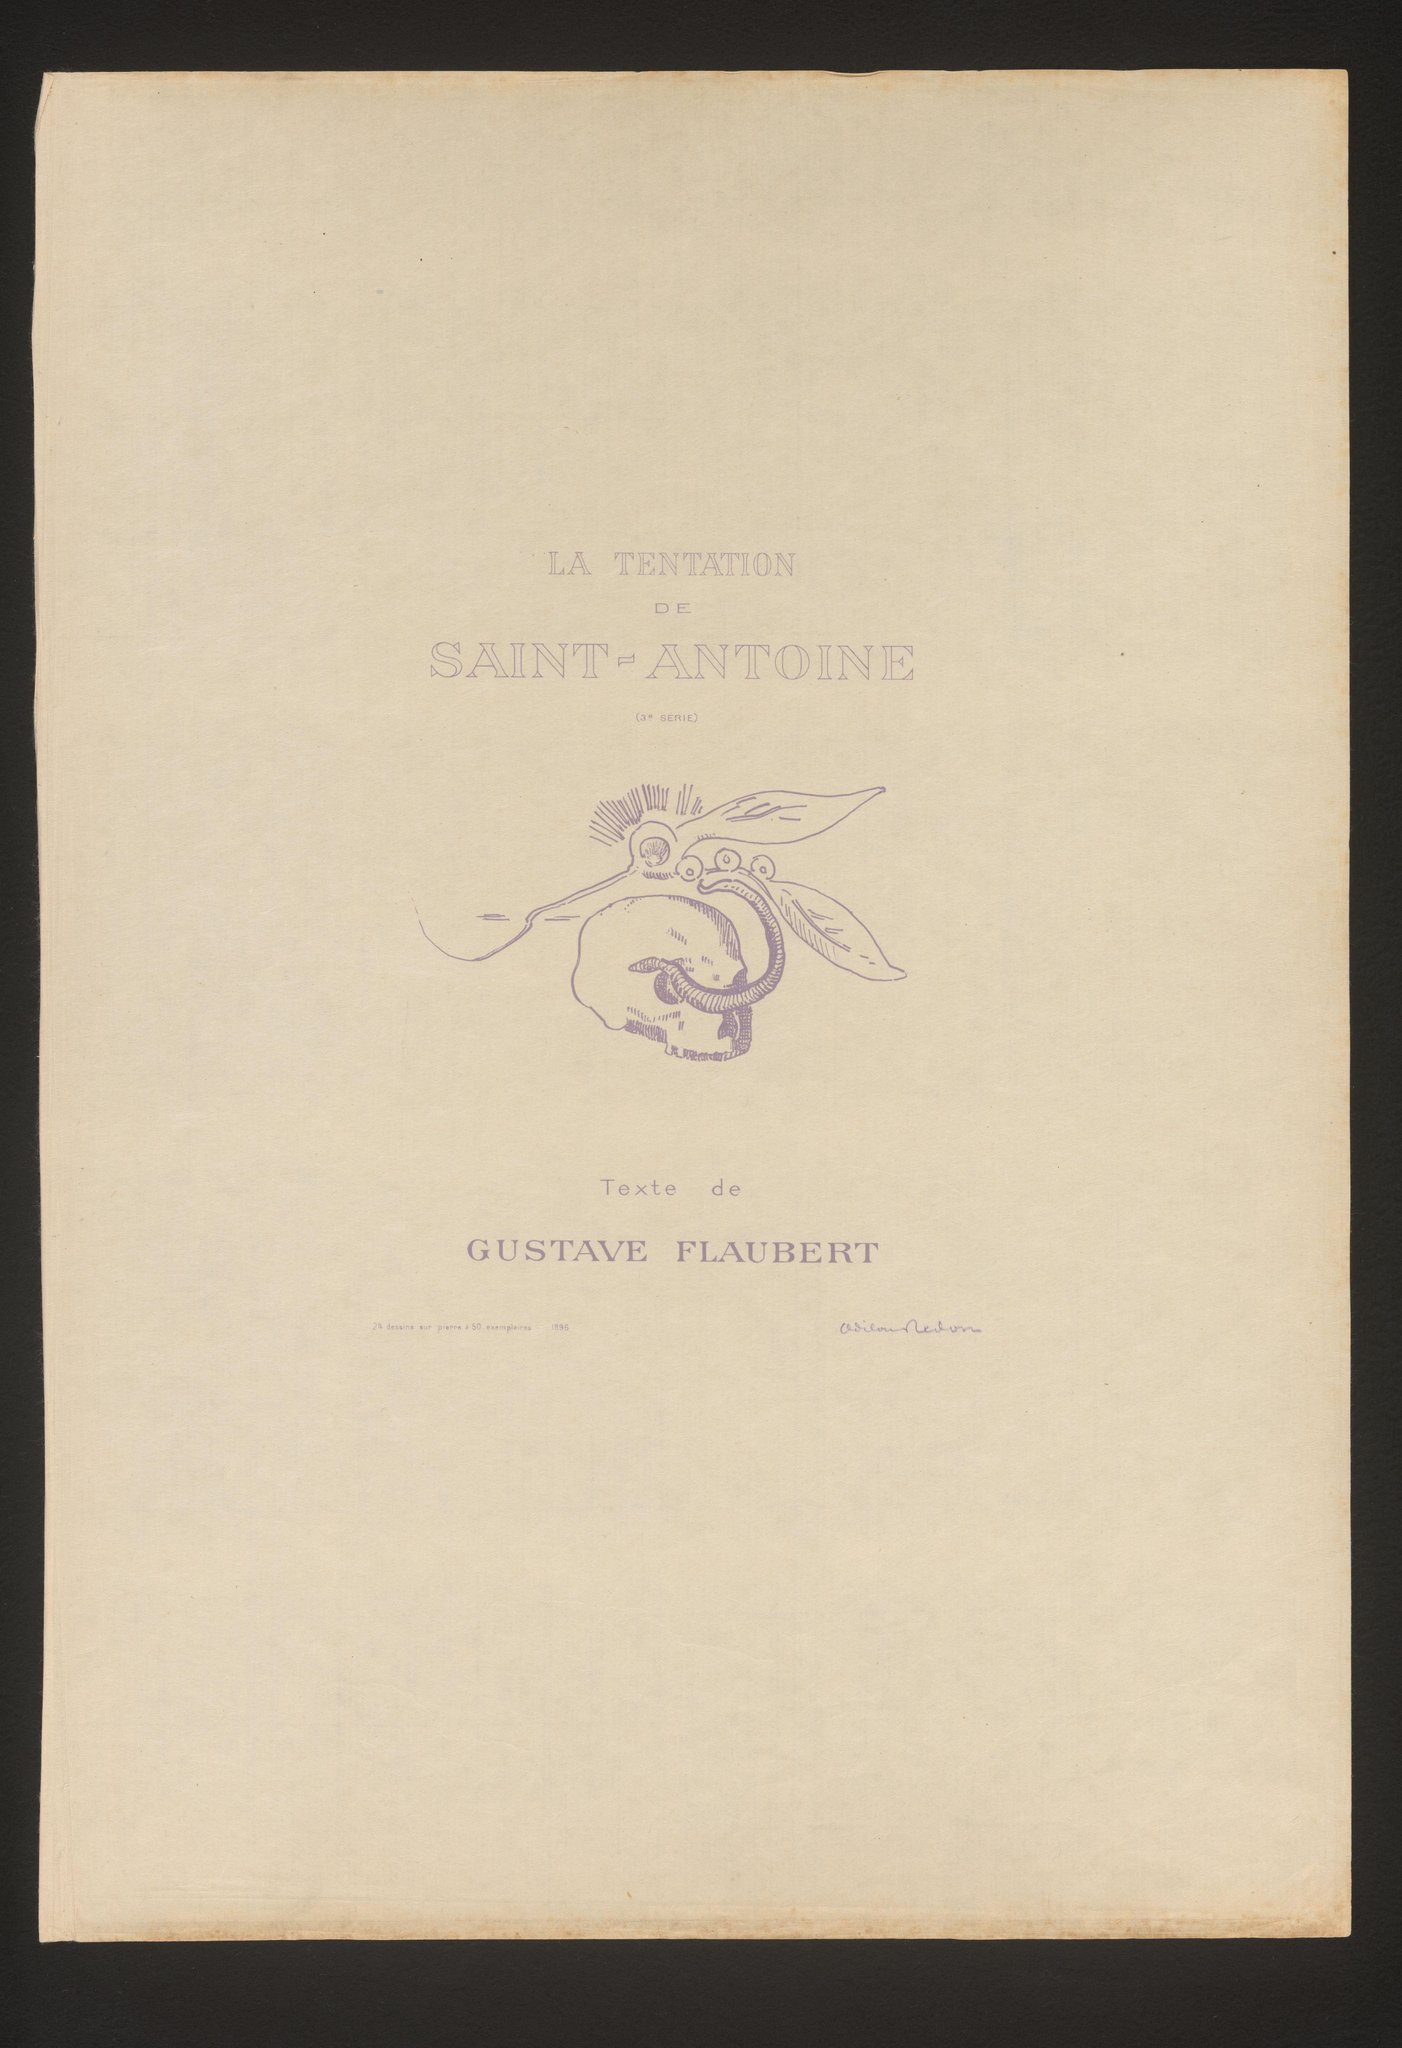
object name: titelprent, frontispice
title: La tentation de Saint-Antoine, 3e. série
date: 1896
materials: paper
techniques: printing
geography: paris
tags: snakes, death's head, skull (symbol of death)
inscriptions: date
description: Een slang kruipt door het oog van een schedel.